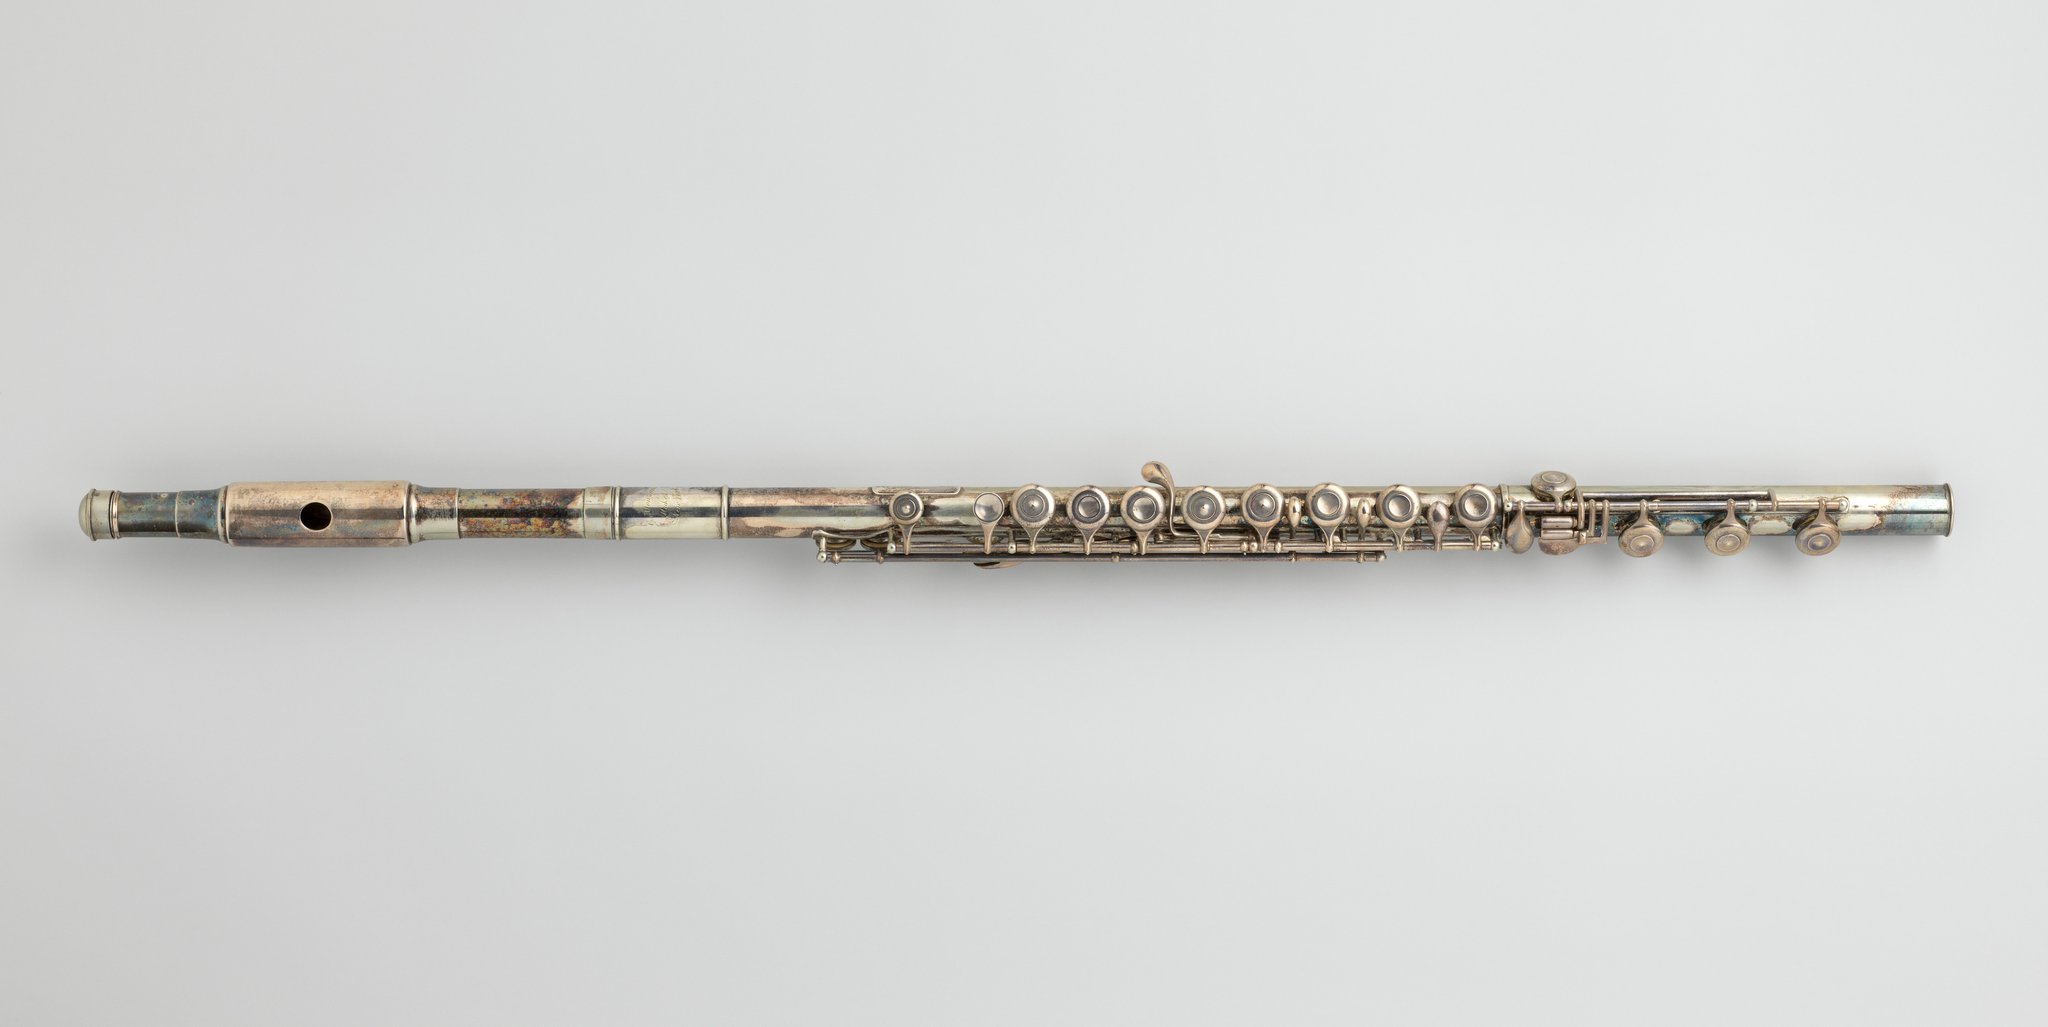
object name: flute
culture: american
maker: charles monzani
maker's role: maker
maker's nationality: american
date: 1867-1869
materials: brass, silver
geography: united states